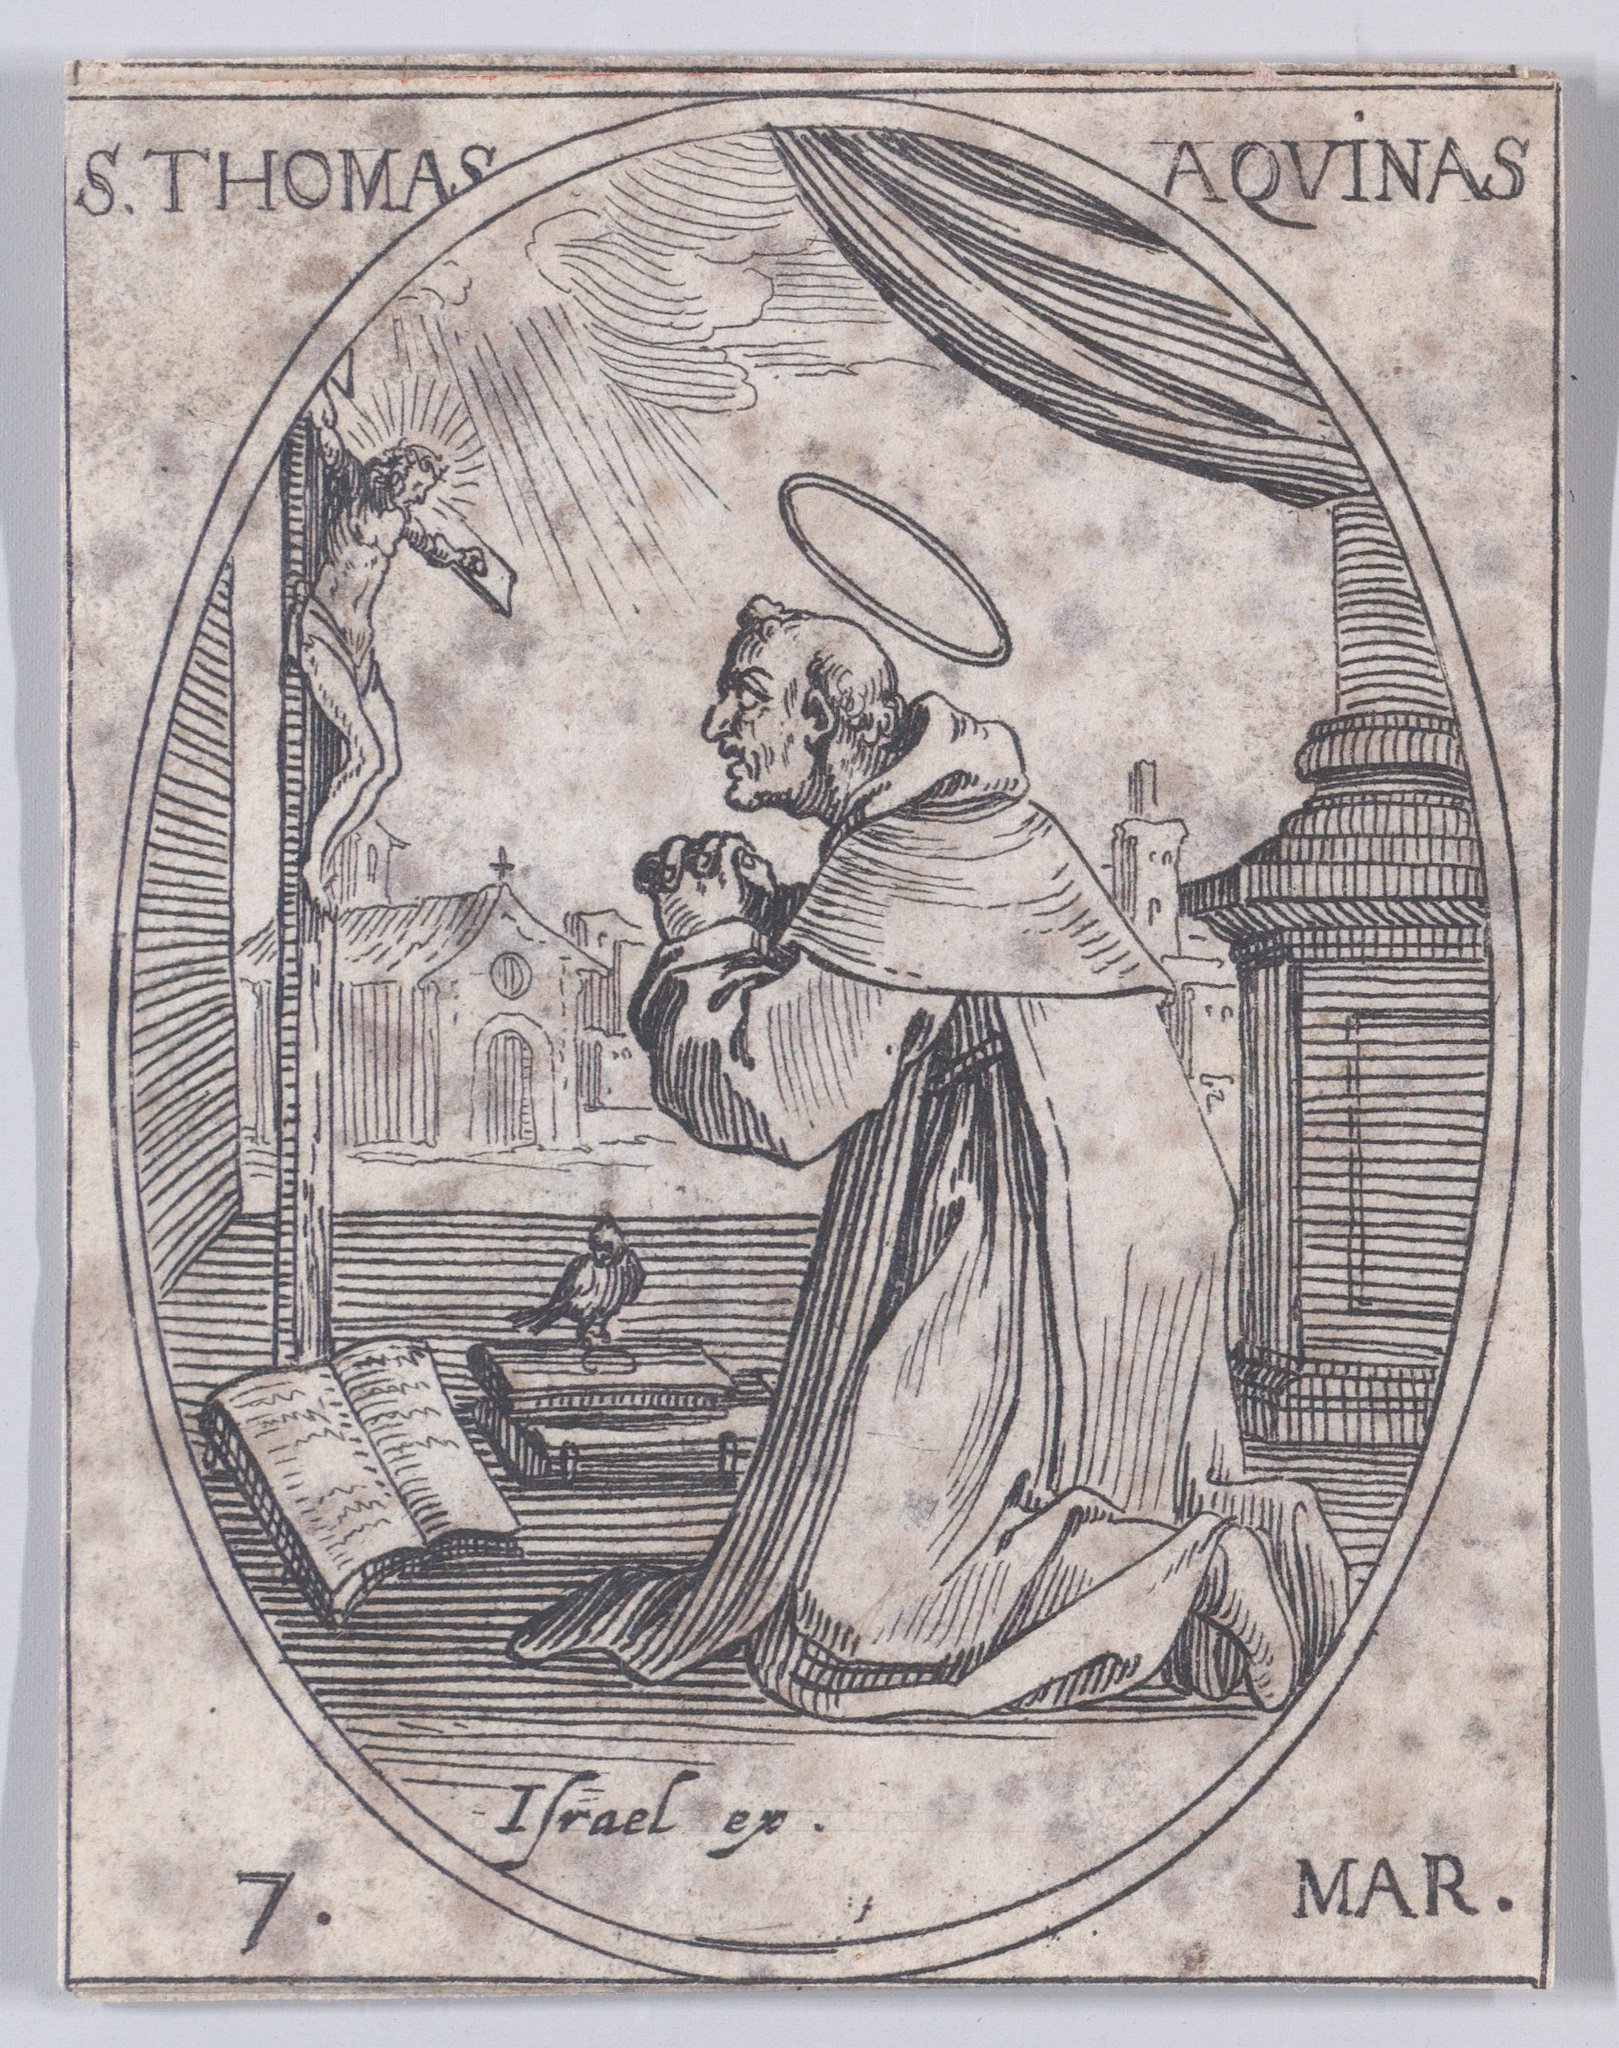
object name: print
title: S. Thomas d'Aquin (St. Thomas Aquinas), March 7th, from "Les Images De Tous Les Saincts et Saintes de L'Année" (Images of All of the Saints and Religious Events of the Year)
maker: jacques callot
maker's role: artist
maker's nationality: french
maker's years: 1592-1635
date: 1636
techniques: etching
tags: men,saints